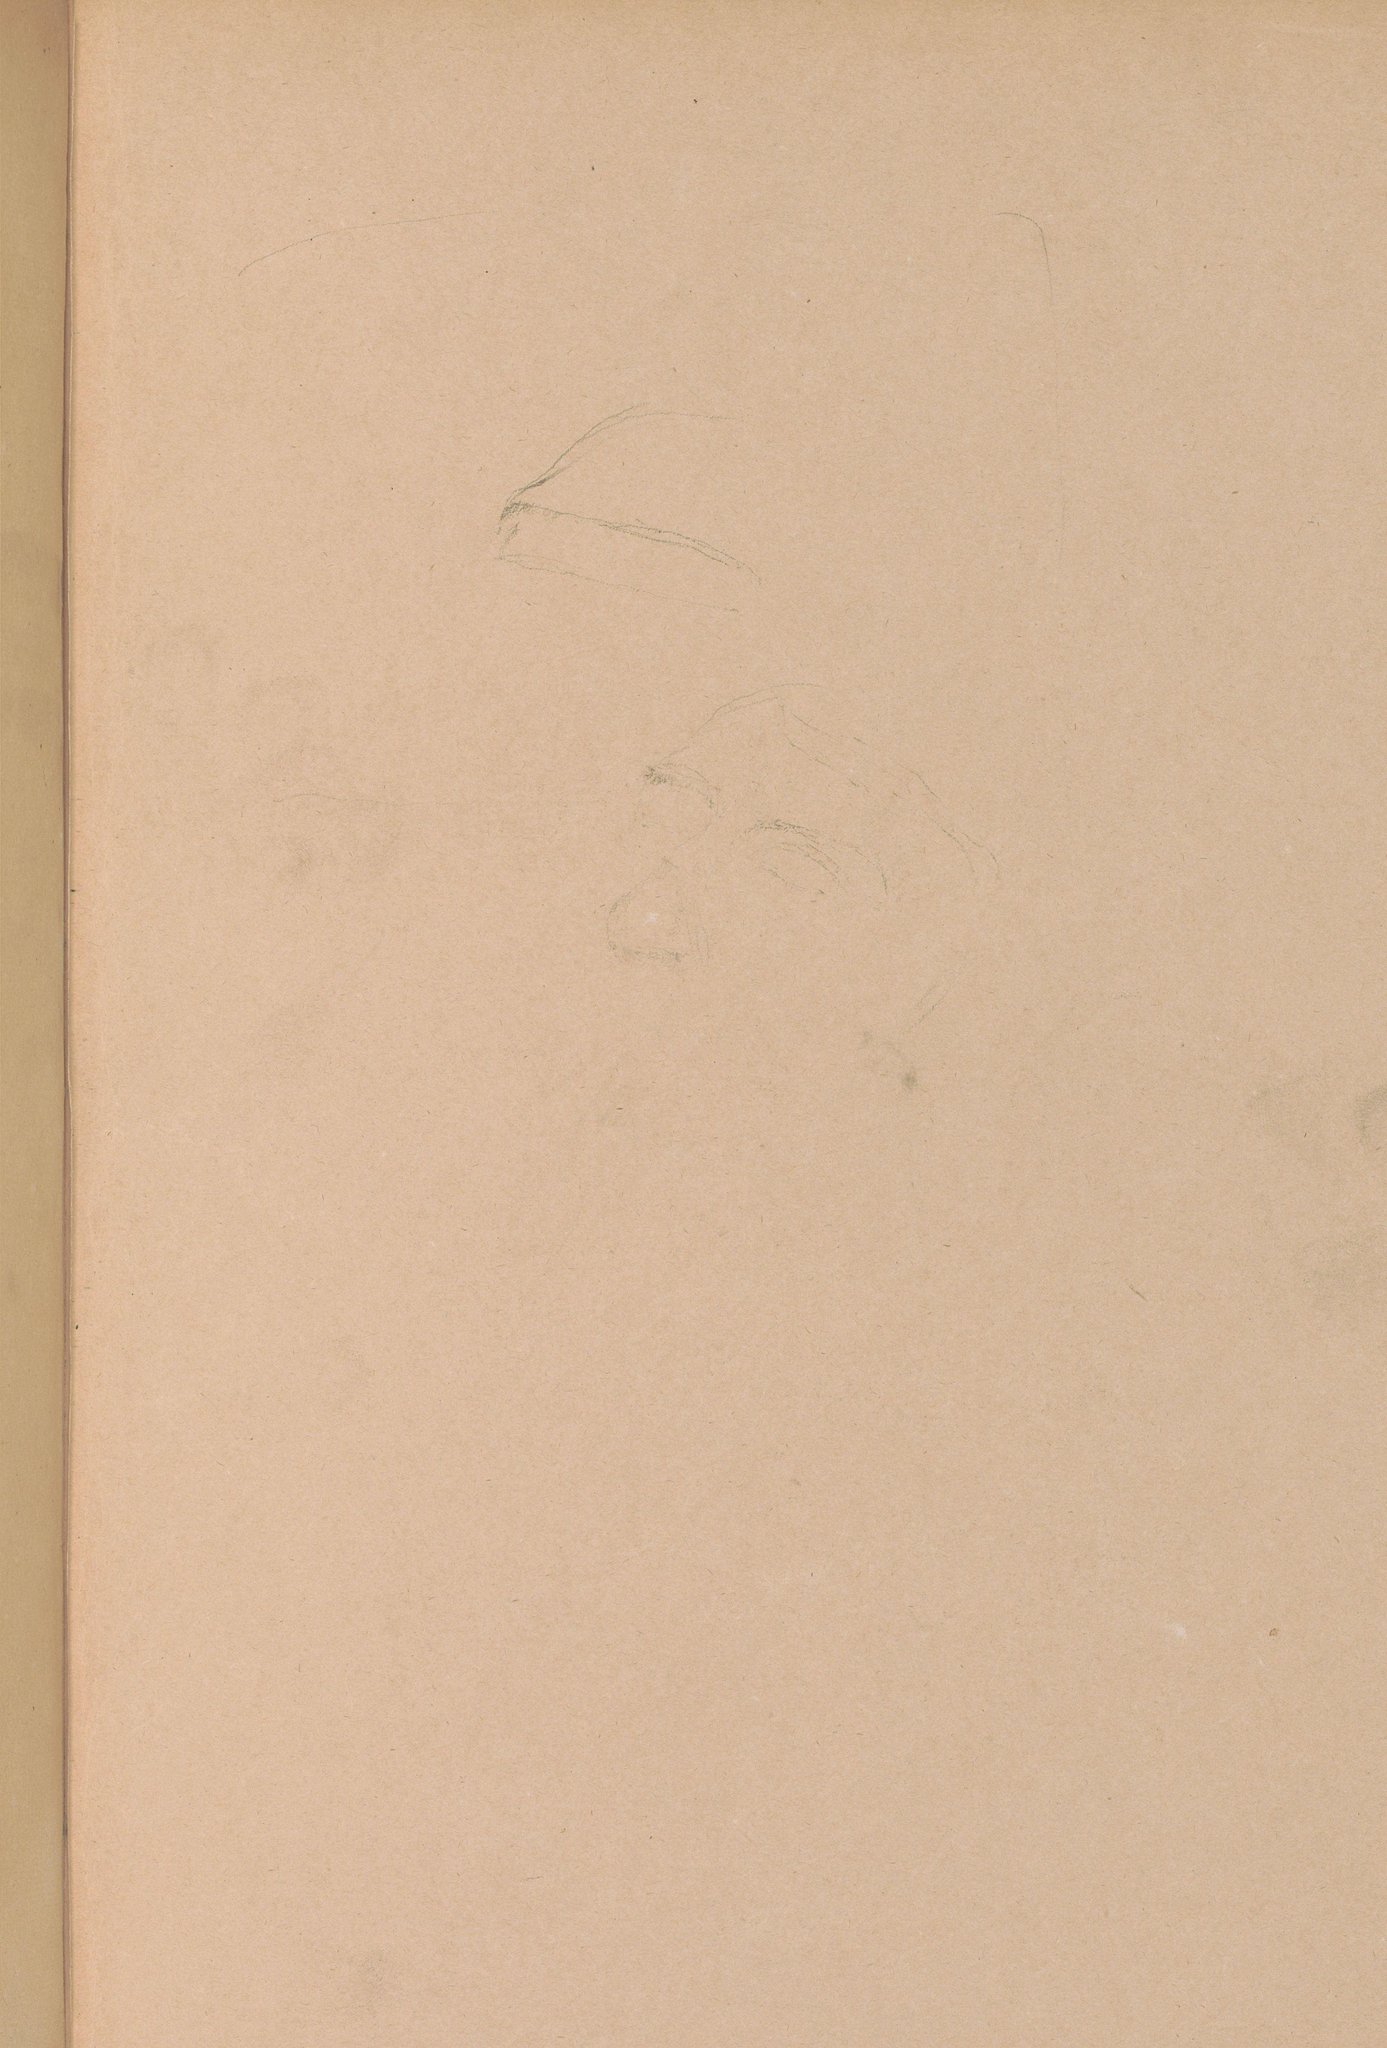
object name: sketchbook leaf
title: Gezicht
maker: willem witsen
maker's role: draughtsman, painter, print maker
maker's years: 1860-1923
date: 1884-1887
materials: chalk, paper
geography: ewijkshoeve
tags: face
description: Pagina 69 uit een schetsboek met 38 bladen.